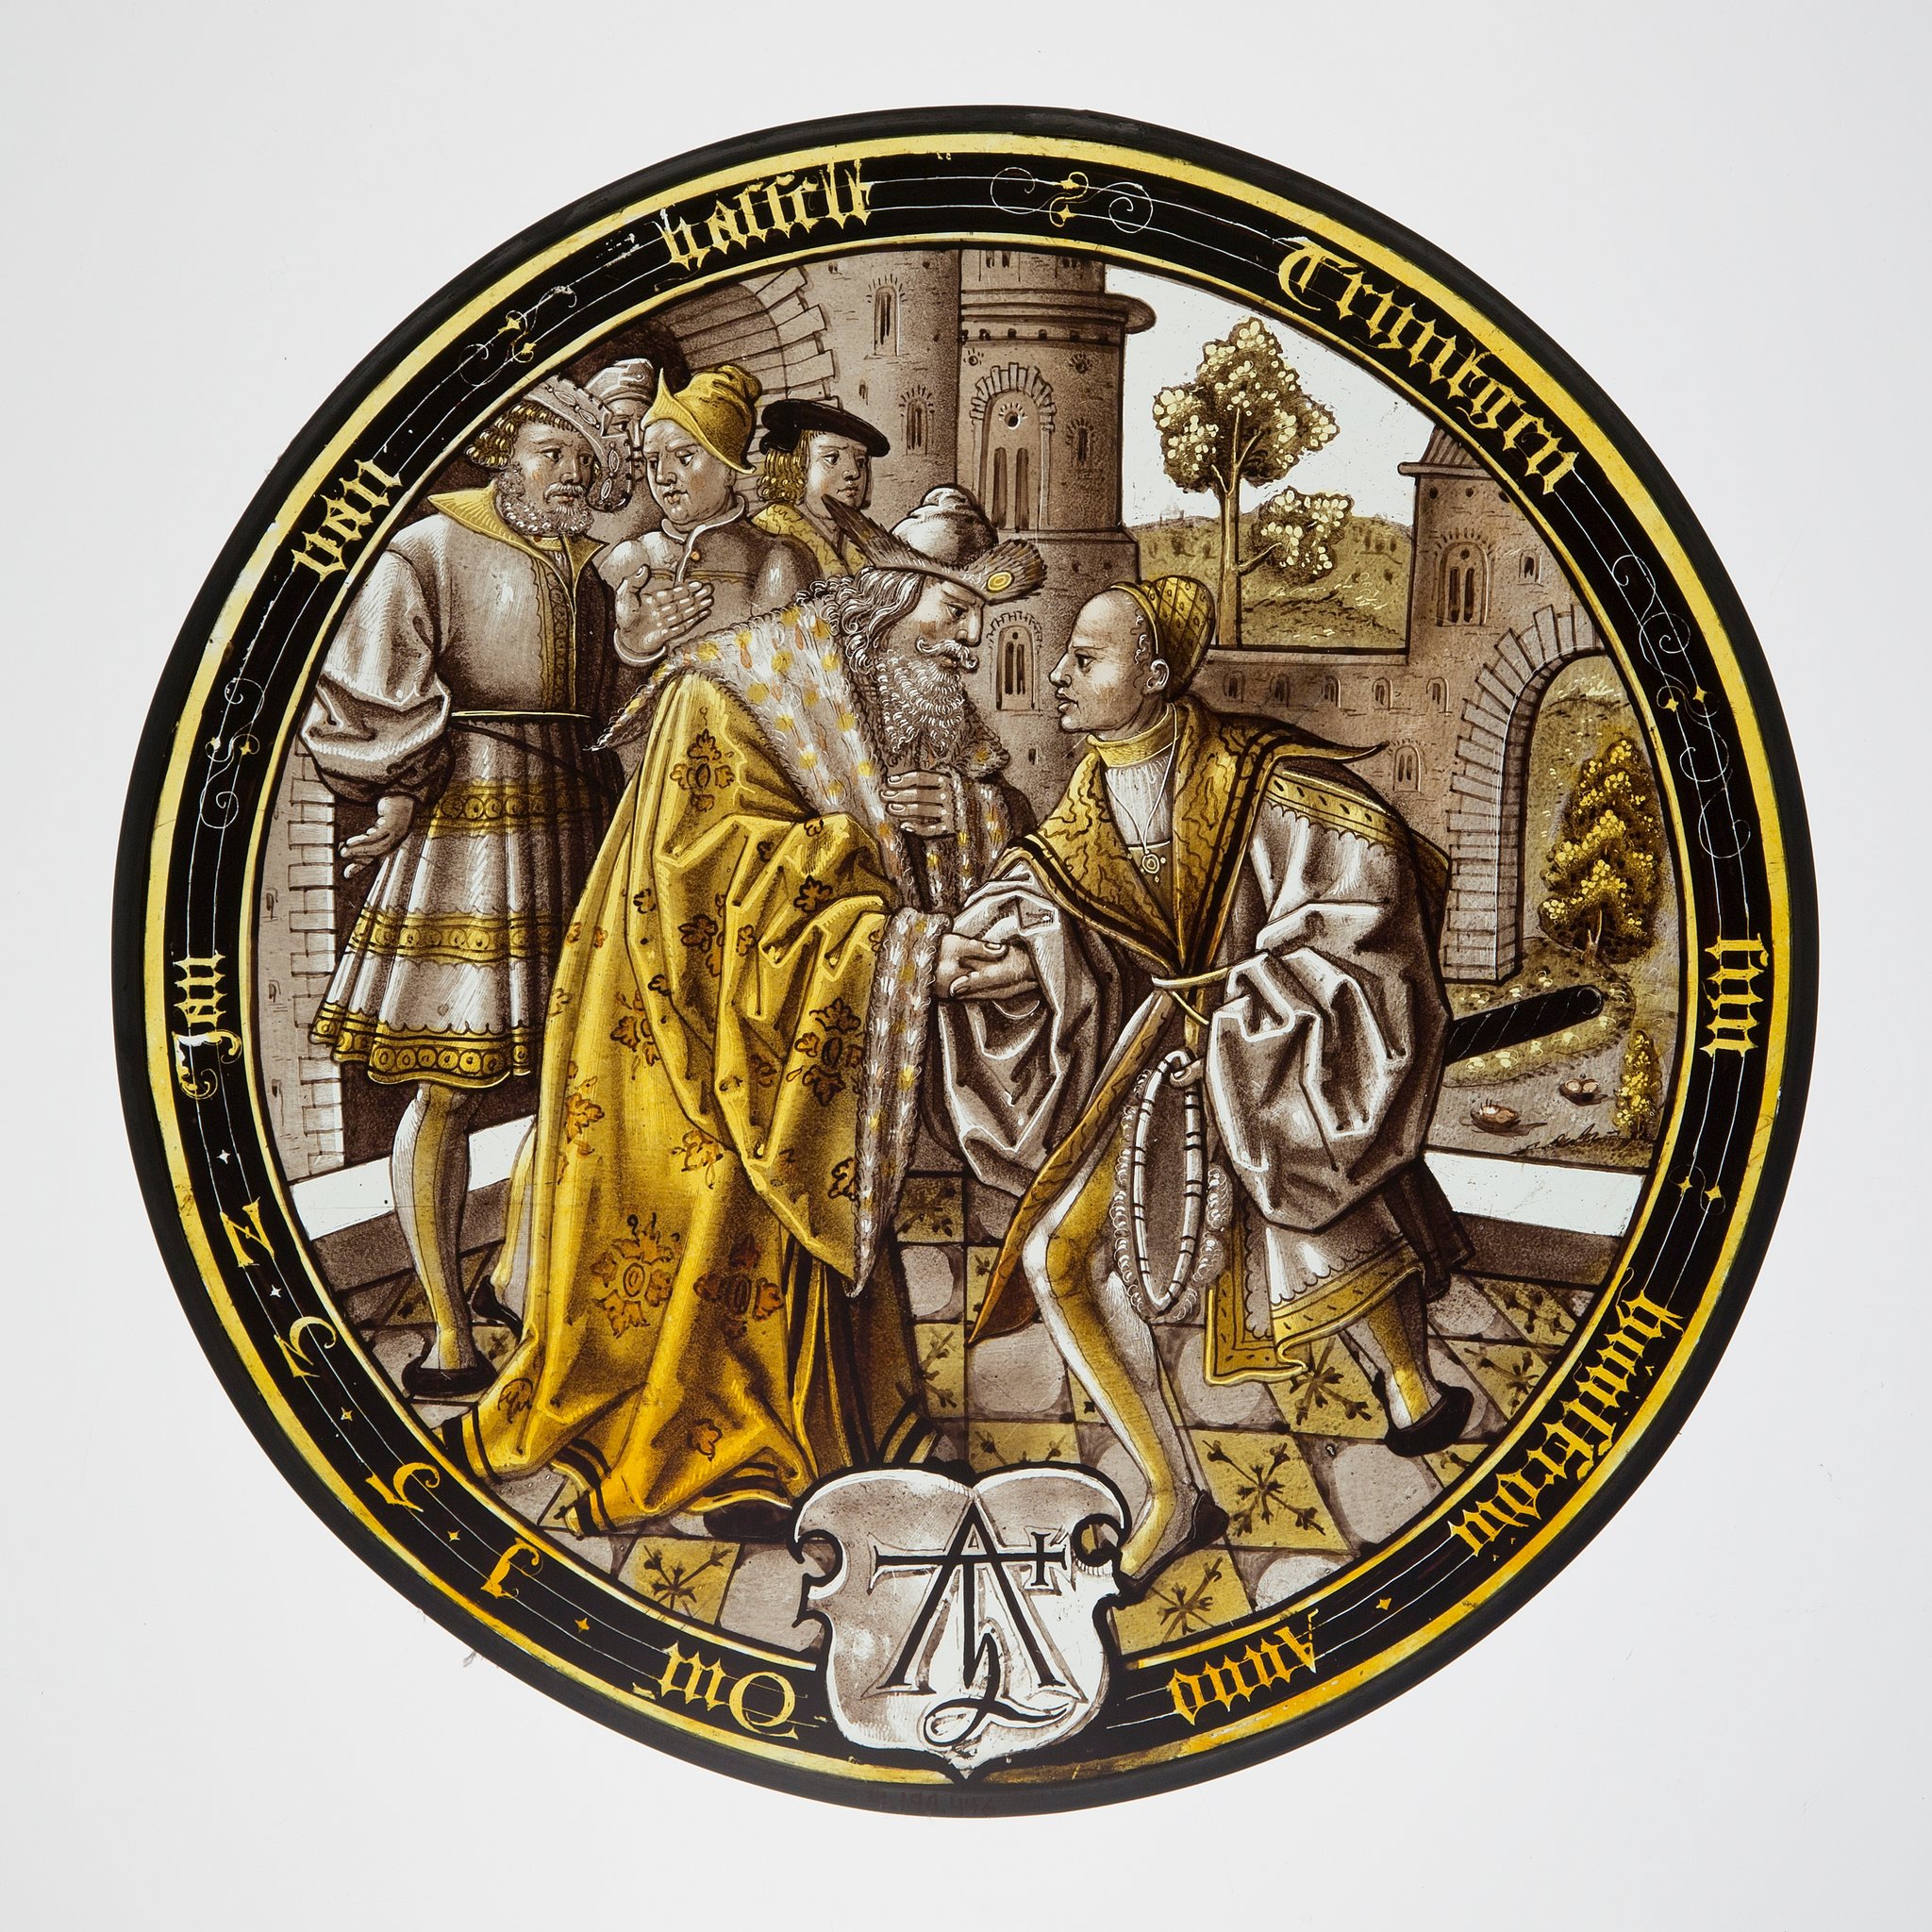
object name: roundel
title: The Prodigal Bids Farewell (one of eight scenes from the story of the Prodigal Son)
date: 1532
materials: glass, paint, pigment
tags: men,trees,insignia